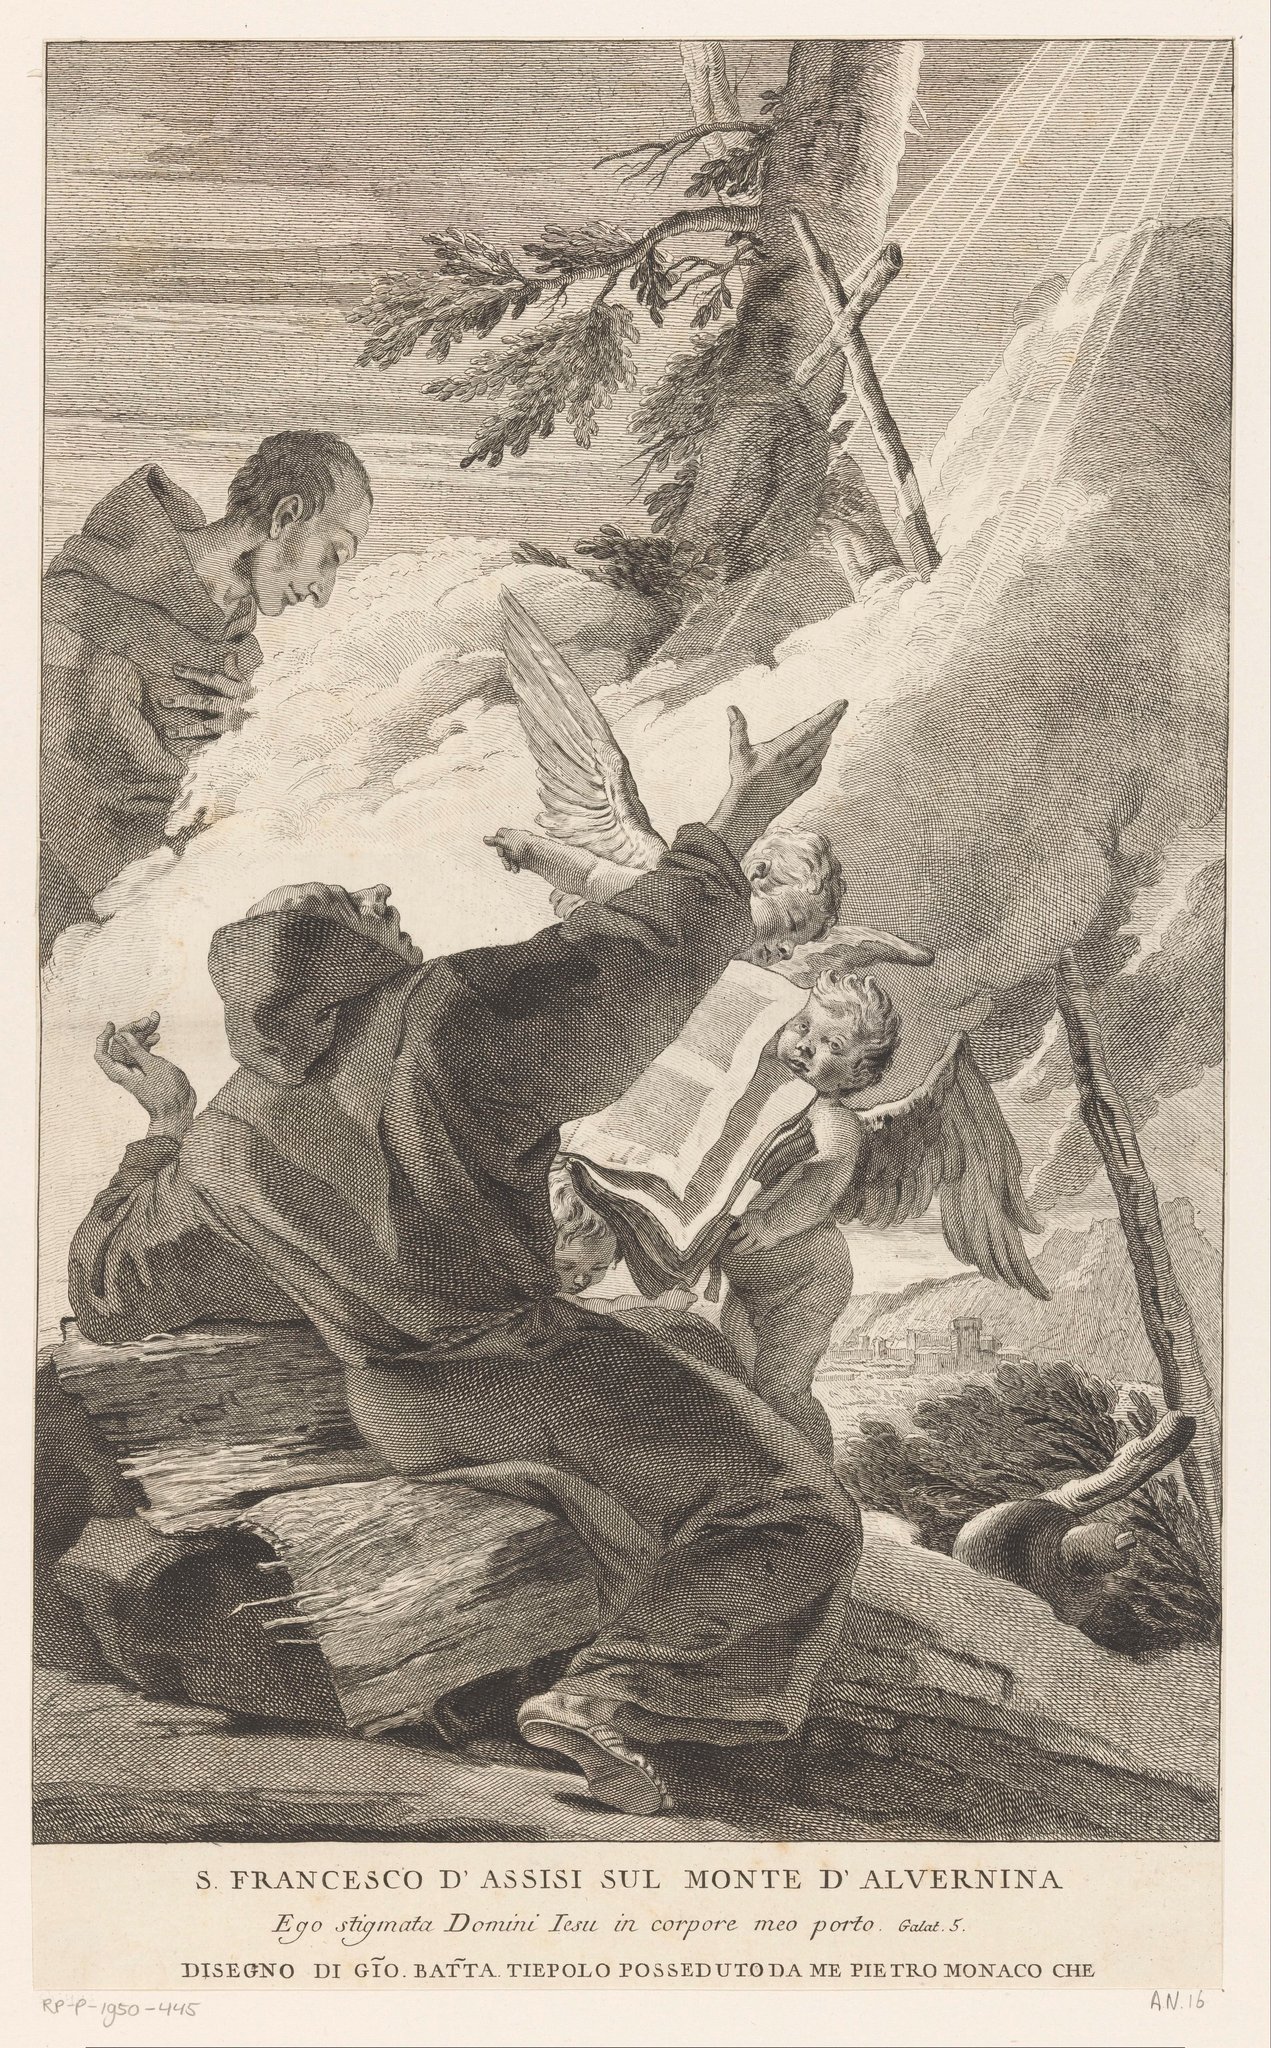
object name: print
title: Nieuwe en Oude Testament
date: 1717-1763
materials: paper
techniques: etching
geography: italy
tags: stigmatization of st. francis of assisi: in retreat on mount alverna, he beholds a vision of christ on the cross enveloped by wings (like a seraph with six wings); rays passing down to the body of the kneeling saint form the marks of the five wounds of christ, founder of the order of friars minor (franciscans), francis(cus) of assisi; possible attributes: book, crucifix, lily, skull, stigmata, cupids: 'amores', 'amoretti', 'putti'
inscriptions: collector's mark: Lugt 2228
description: De heilige Franciscus van Assisi, op de rug gezien, ontvangt de kruiswonden van een crucifix dat boven hem aan de hemel is verschenen. Voor hem staan putti die hem een boek voorhouden. Tekst in ondermarge.